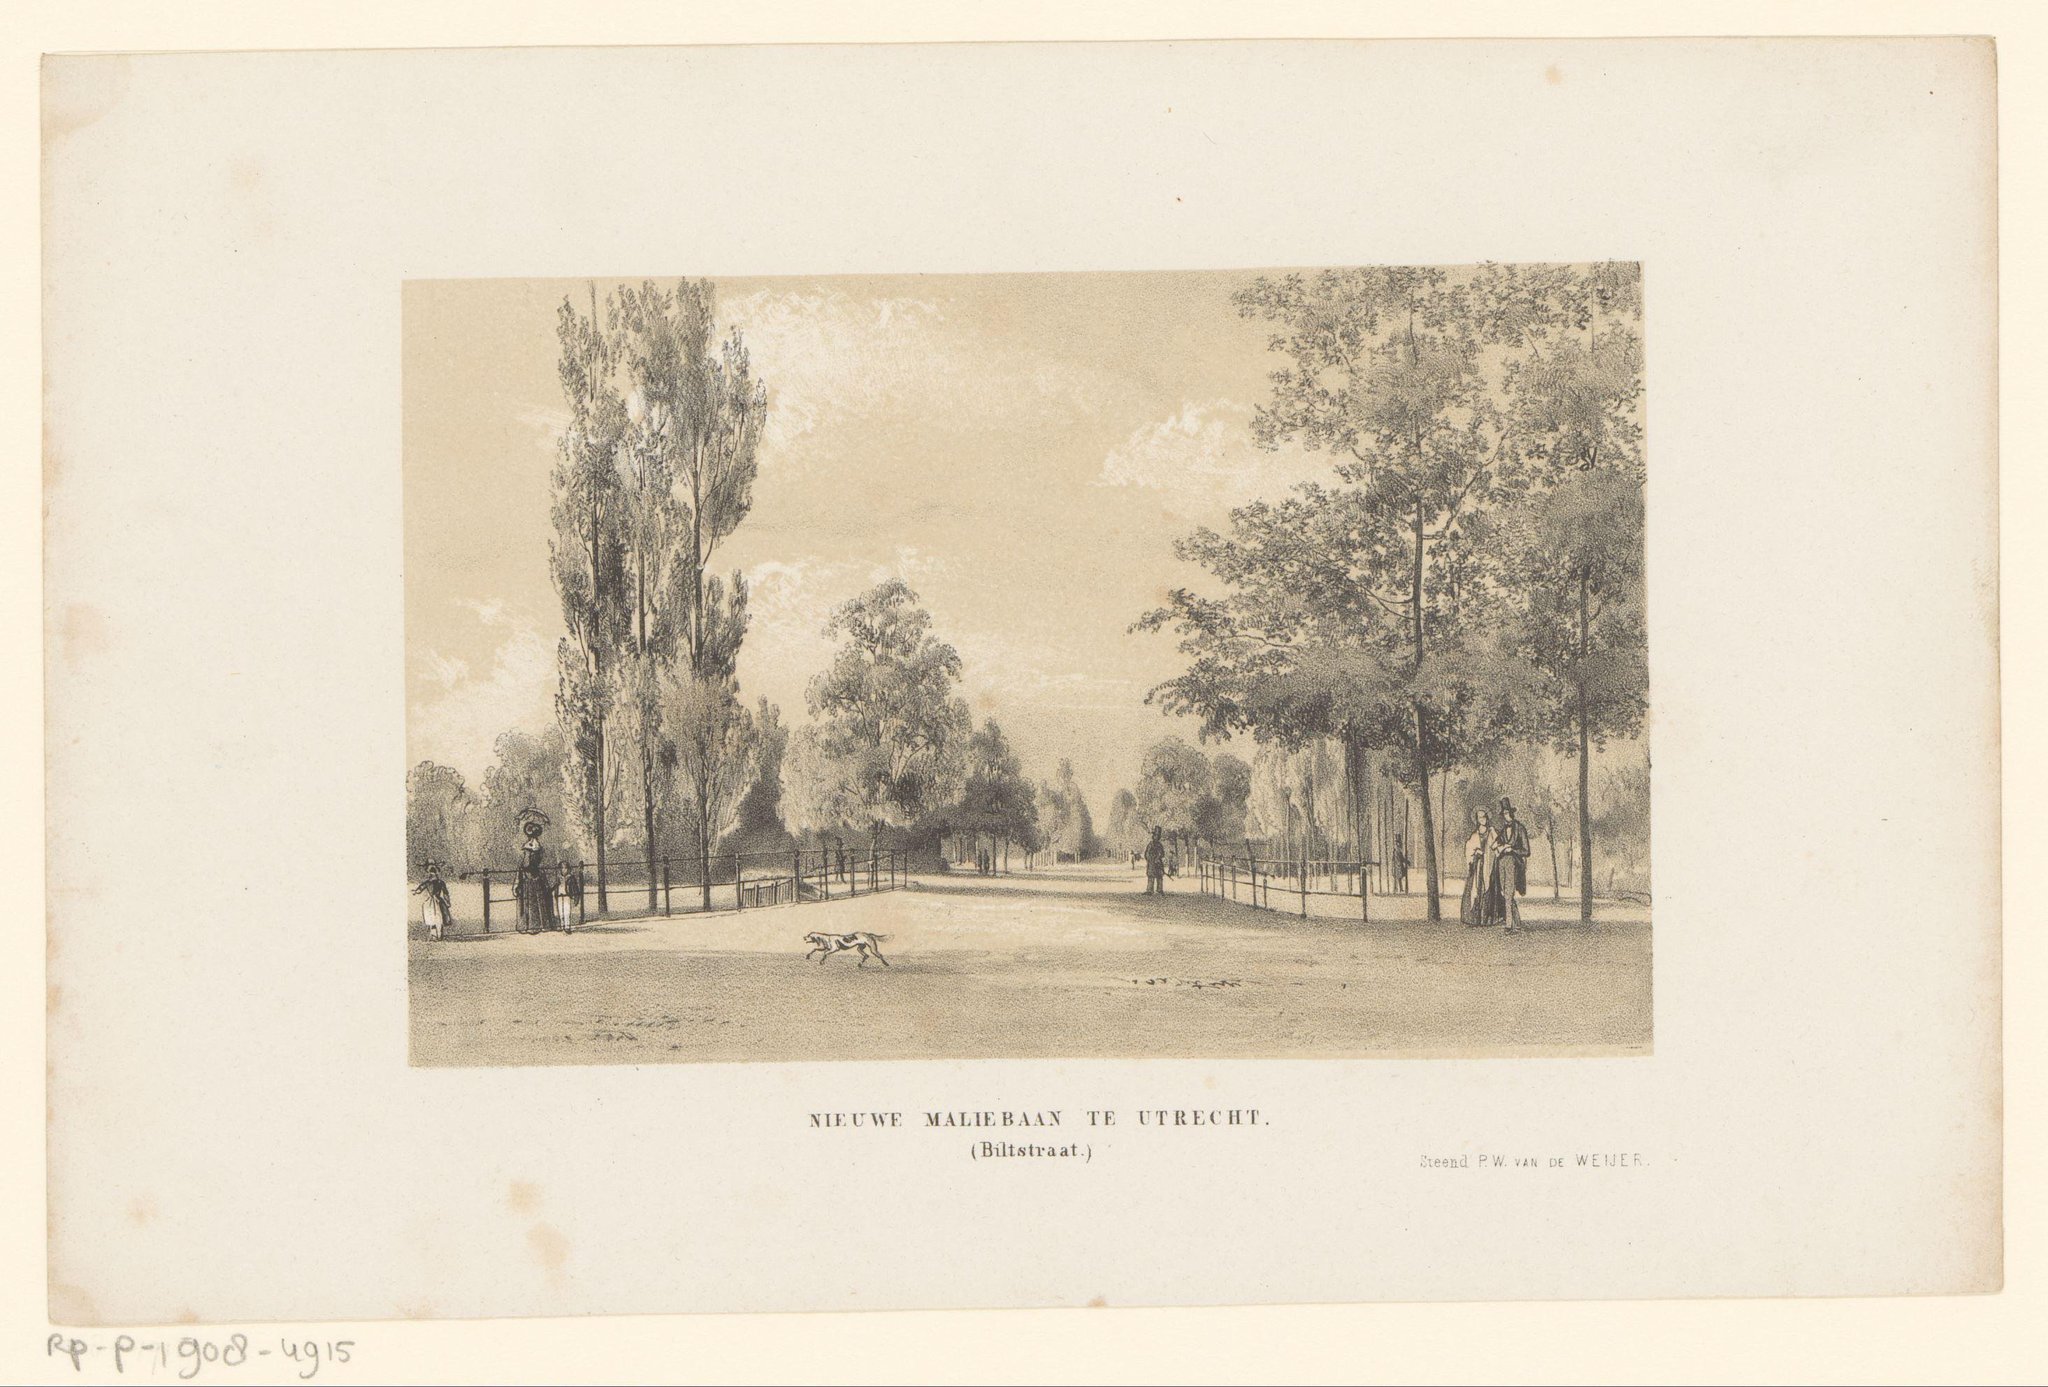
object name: print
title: Gezicht op de Maliebaan in Utrecht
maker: pieter wilhelmus van de weijer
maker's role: print maker, printer, publisher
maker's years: 1816-1880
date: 1856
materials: paper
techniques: tone lithography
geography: utrecht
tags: city-view, and landscape with man-made constructions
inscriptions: collector's mark: Lugt 2228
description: Mogelijk maakte deze prent deel uit van: Utrecht's Album, Utrecht: W.F.Dannenfelser, 1856.